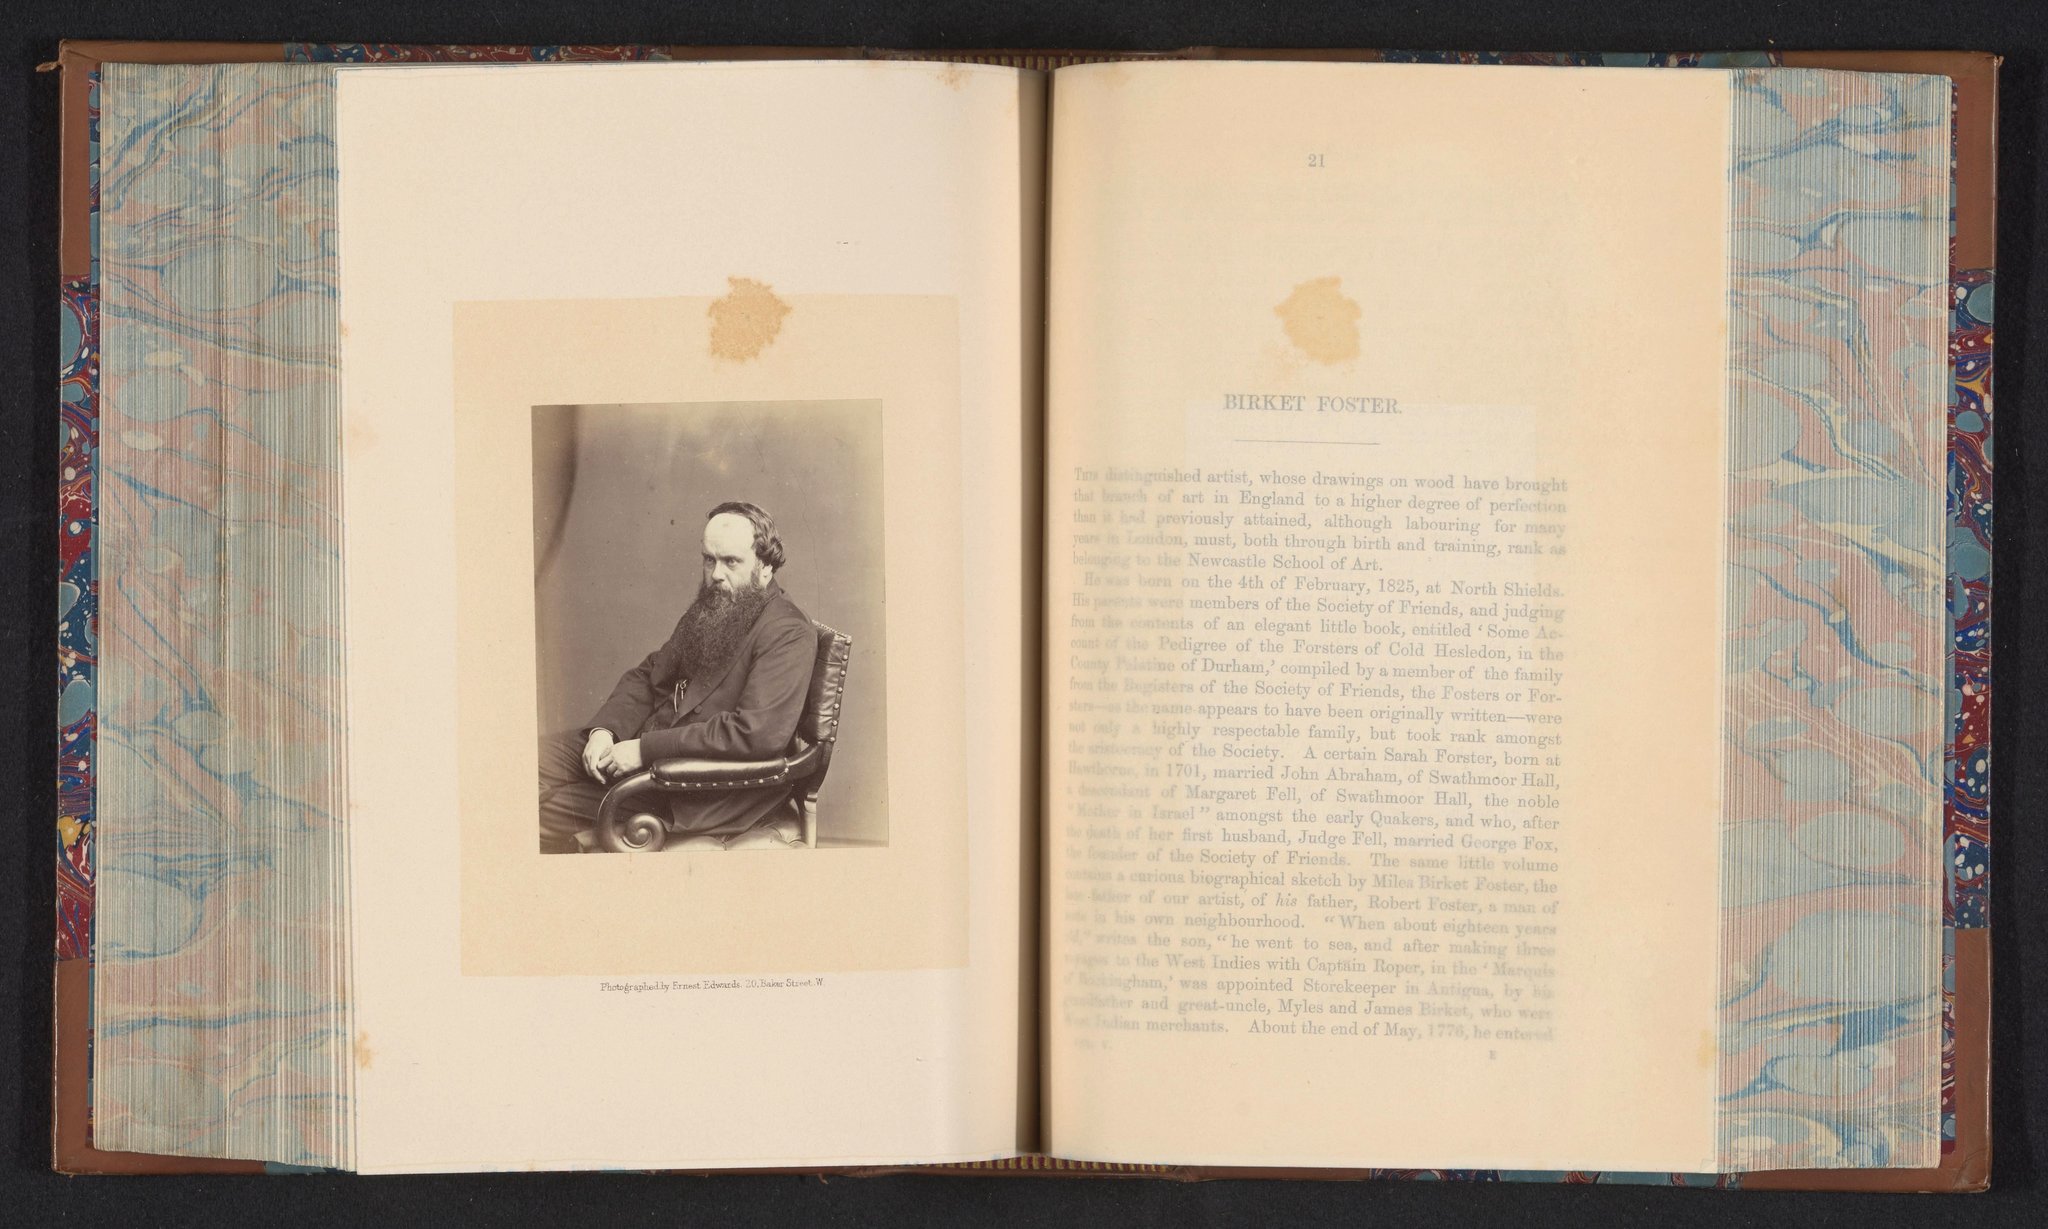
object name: page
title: Portret van Myles Birket Foster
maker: ernest edwards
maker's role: fotograaf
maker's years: 1837-1903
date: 1856-1866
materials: photographic support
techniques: albumen print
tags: graphic artist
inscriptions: name: ‘Photographed by Ernest Edwards, 20, Baker Street. W.’